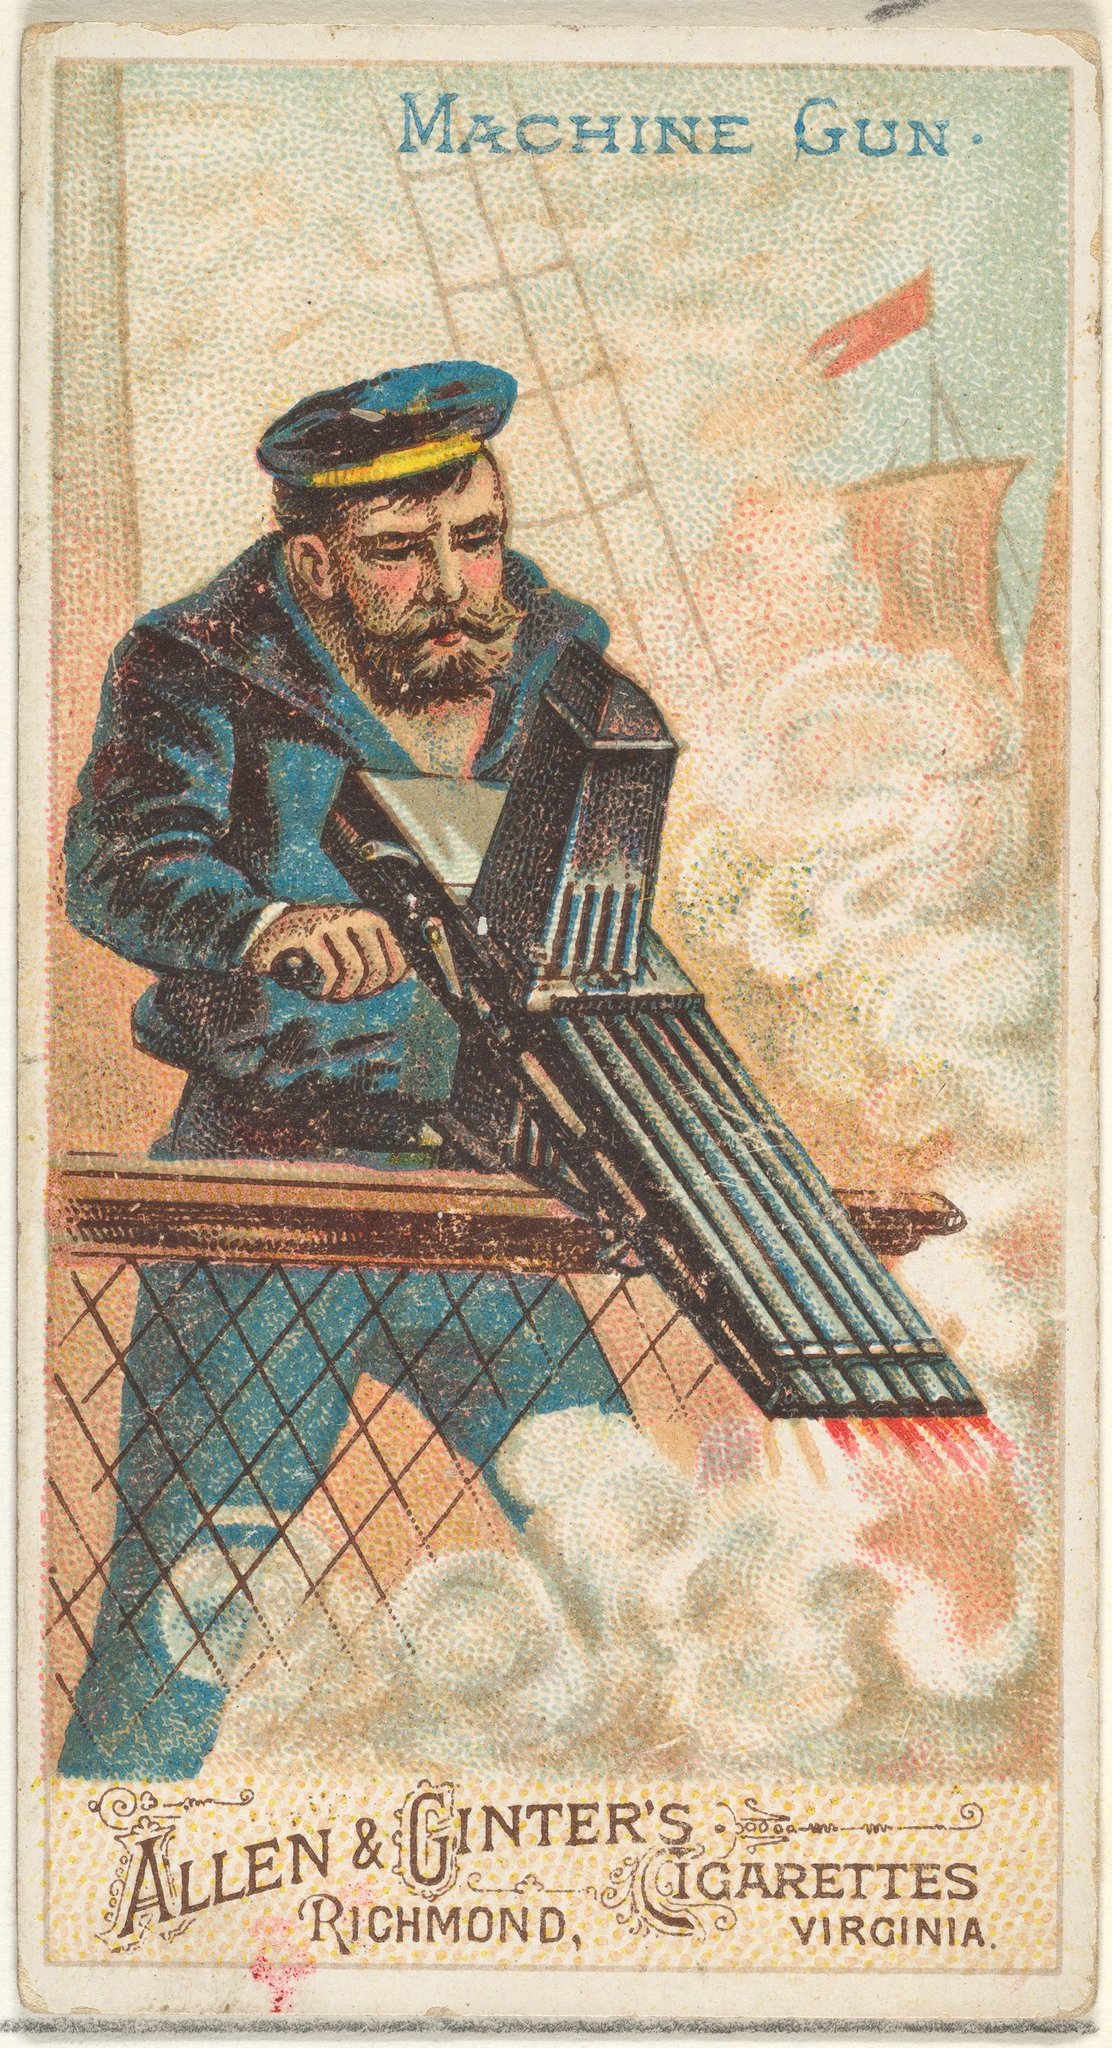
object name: print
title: Machine Gun, from the Arms of All Nations series (N3) for Allen & Ginter Cigarettes Brands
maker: allen & ginter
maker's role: publisher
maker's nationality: american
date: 1887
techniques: color lithograph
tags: firearms,men